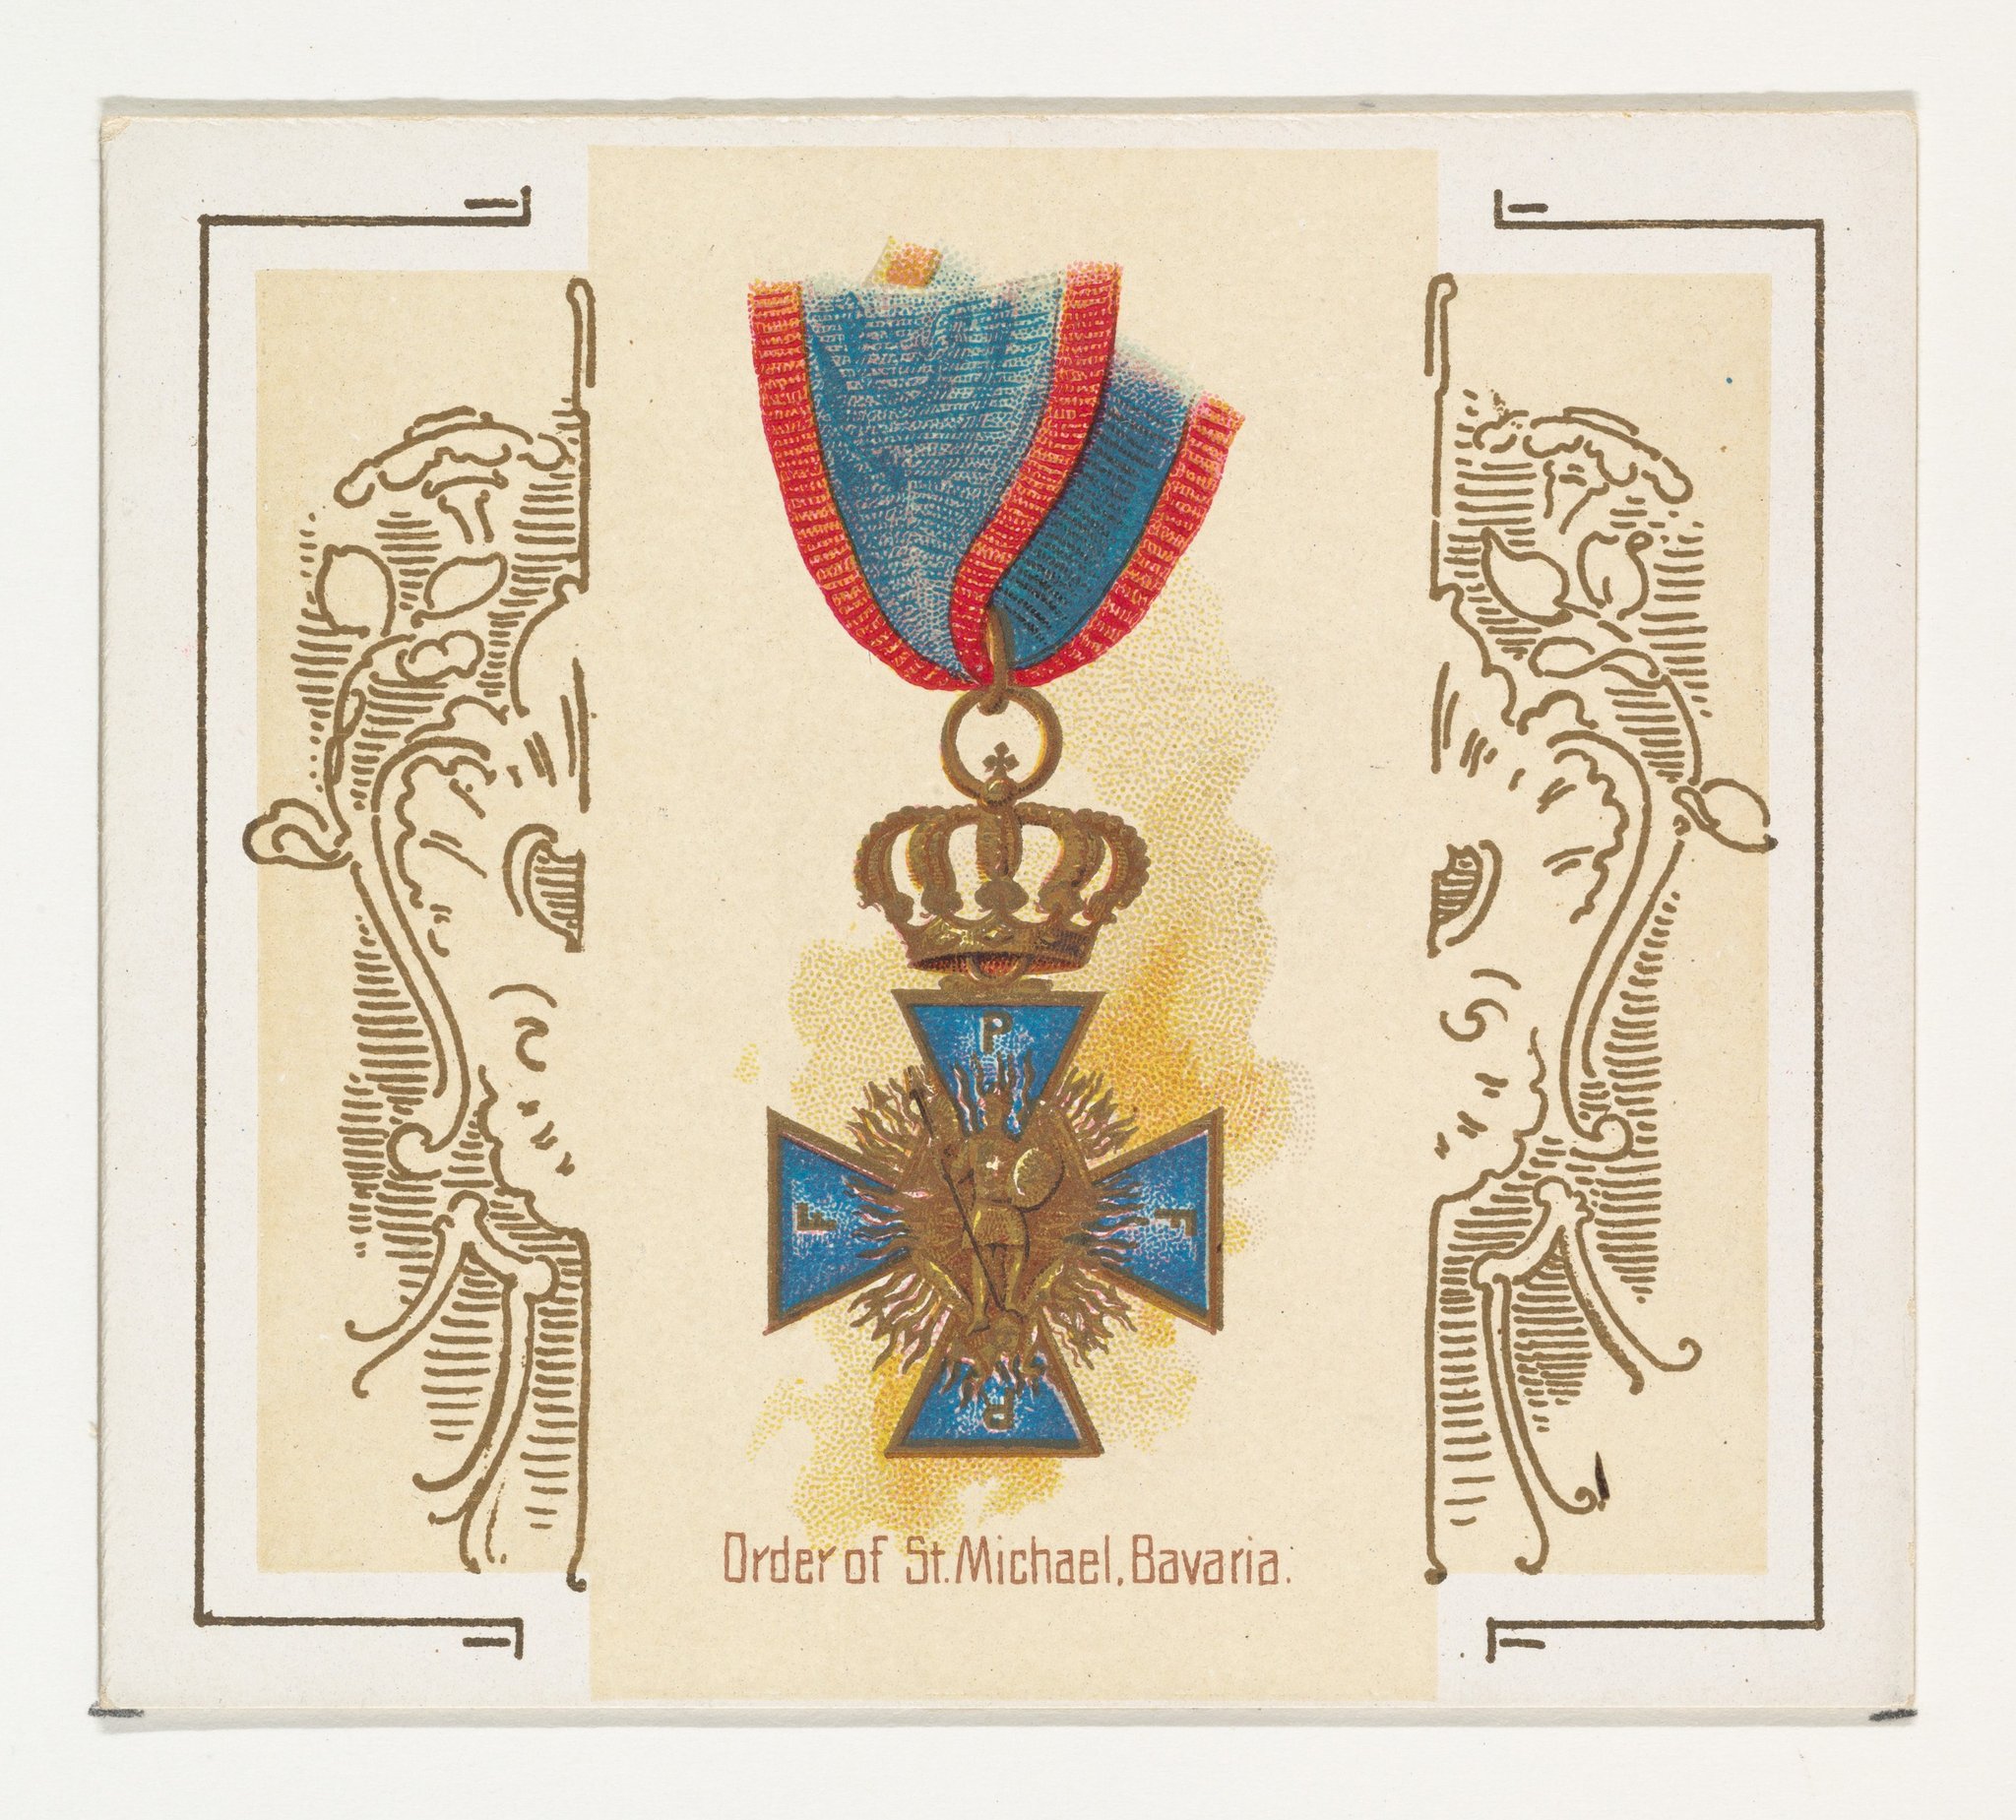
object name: print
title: Order of Saint Michael, Bavaria, from the World's Decorations series (N44) for Allen & Ginter Cigarettes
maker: allen & ginter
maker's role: publisher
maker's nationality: american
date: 1890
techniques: color lithograph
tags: medals